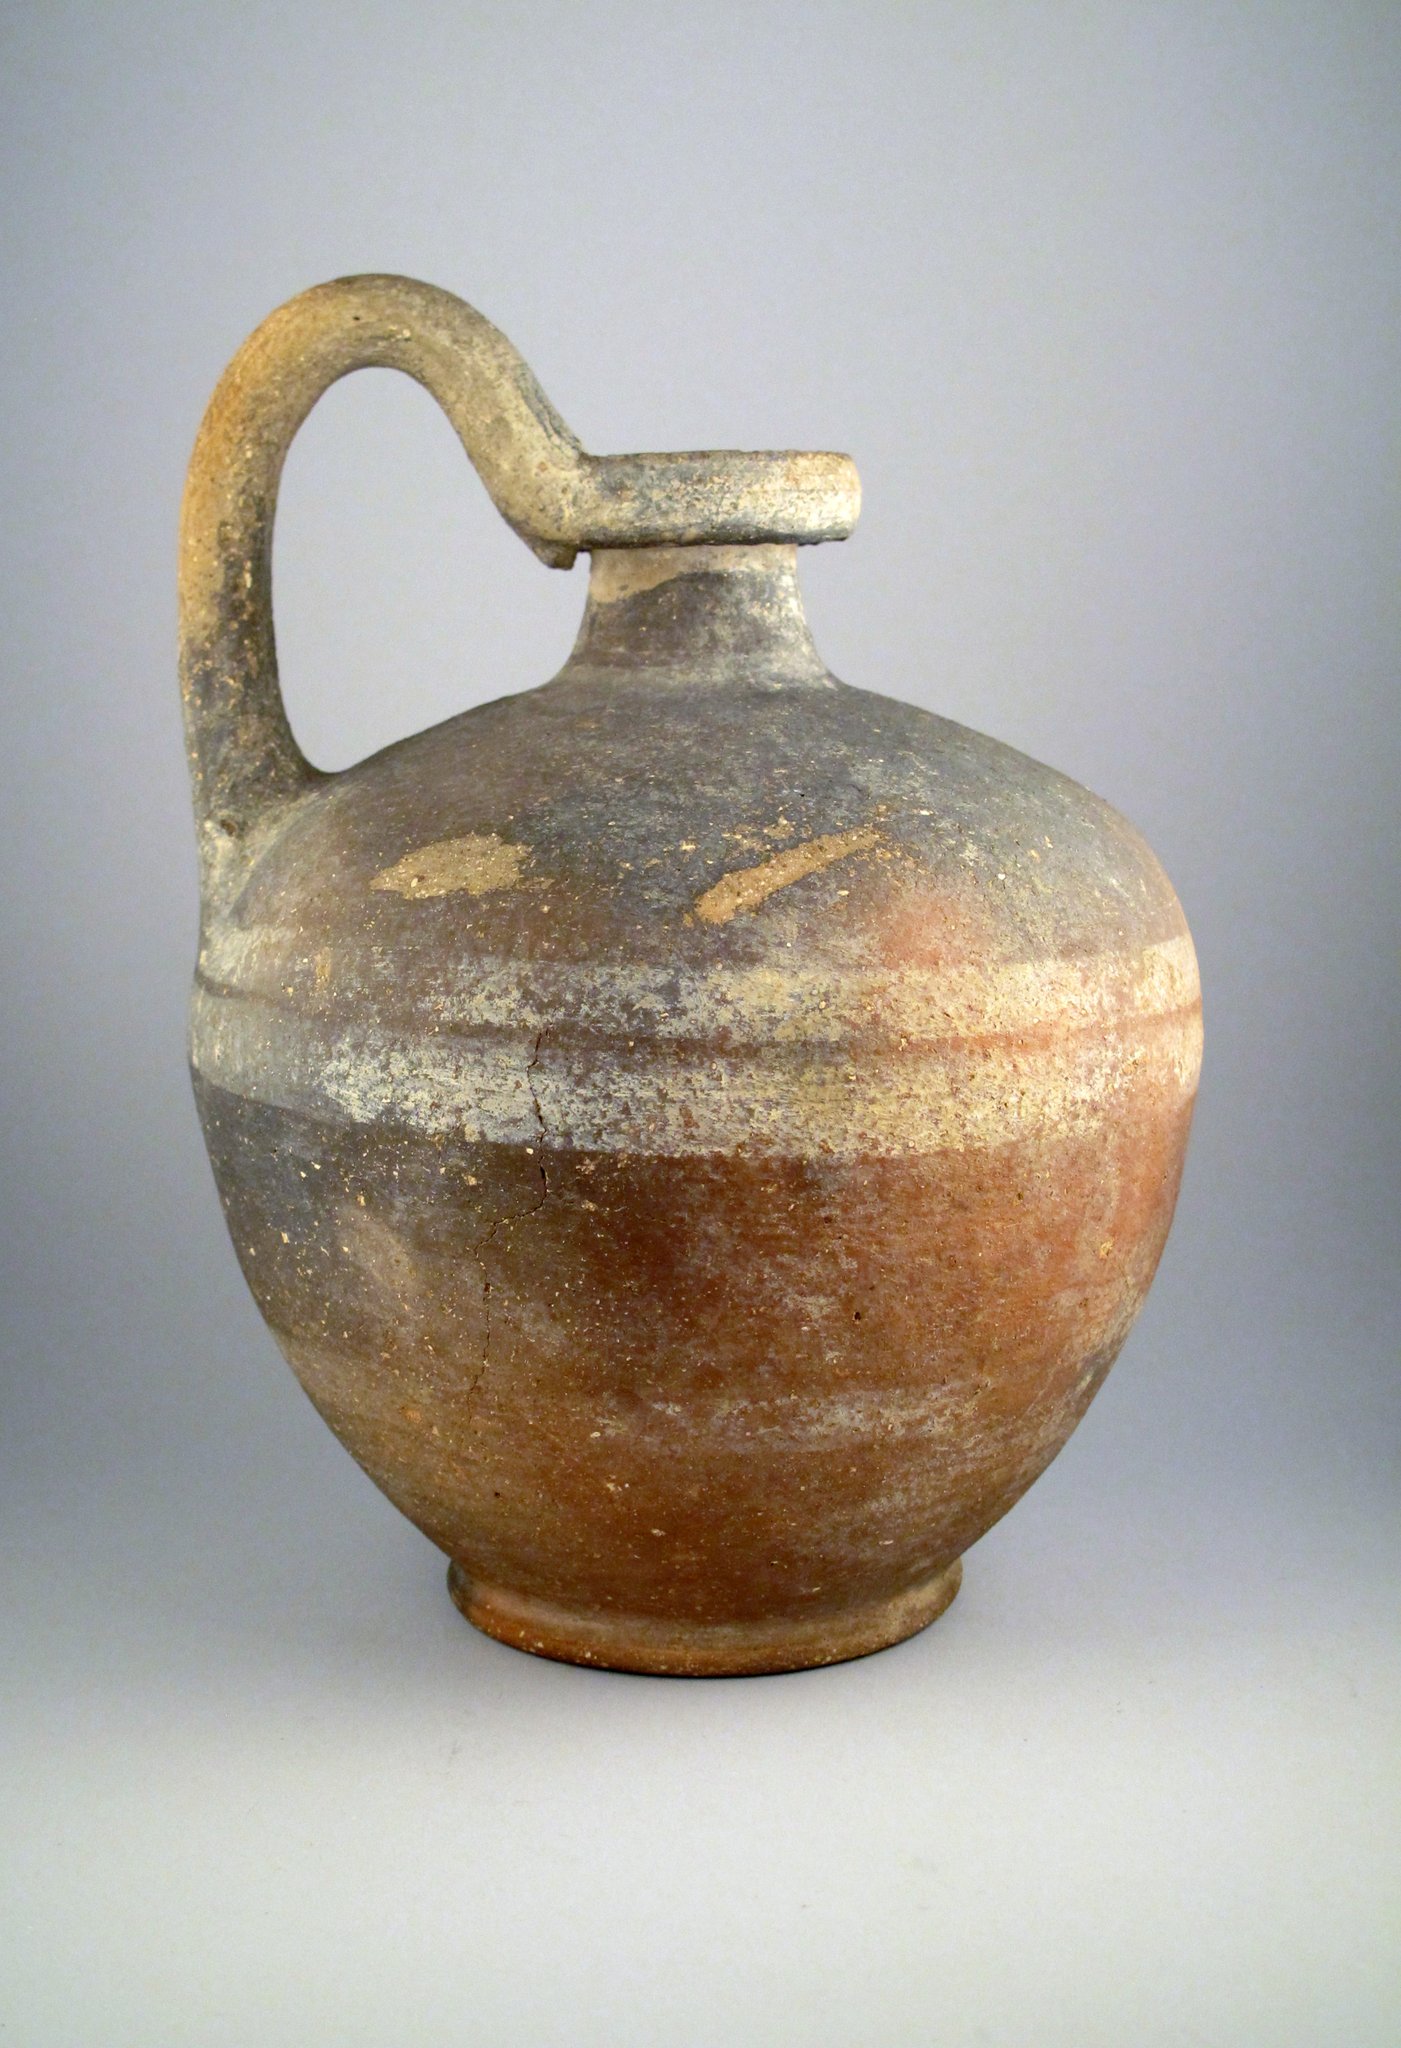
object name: jug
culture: cypriot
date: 480-400 BCE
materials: terracotta